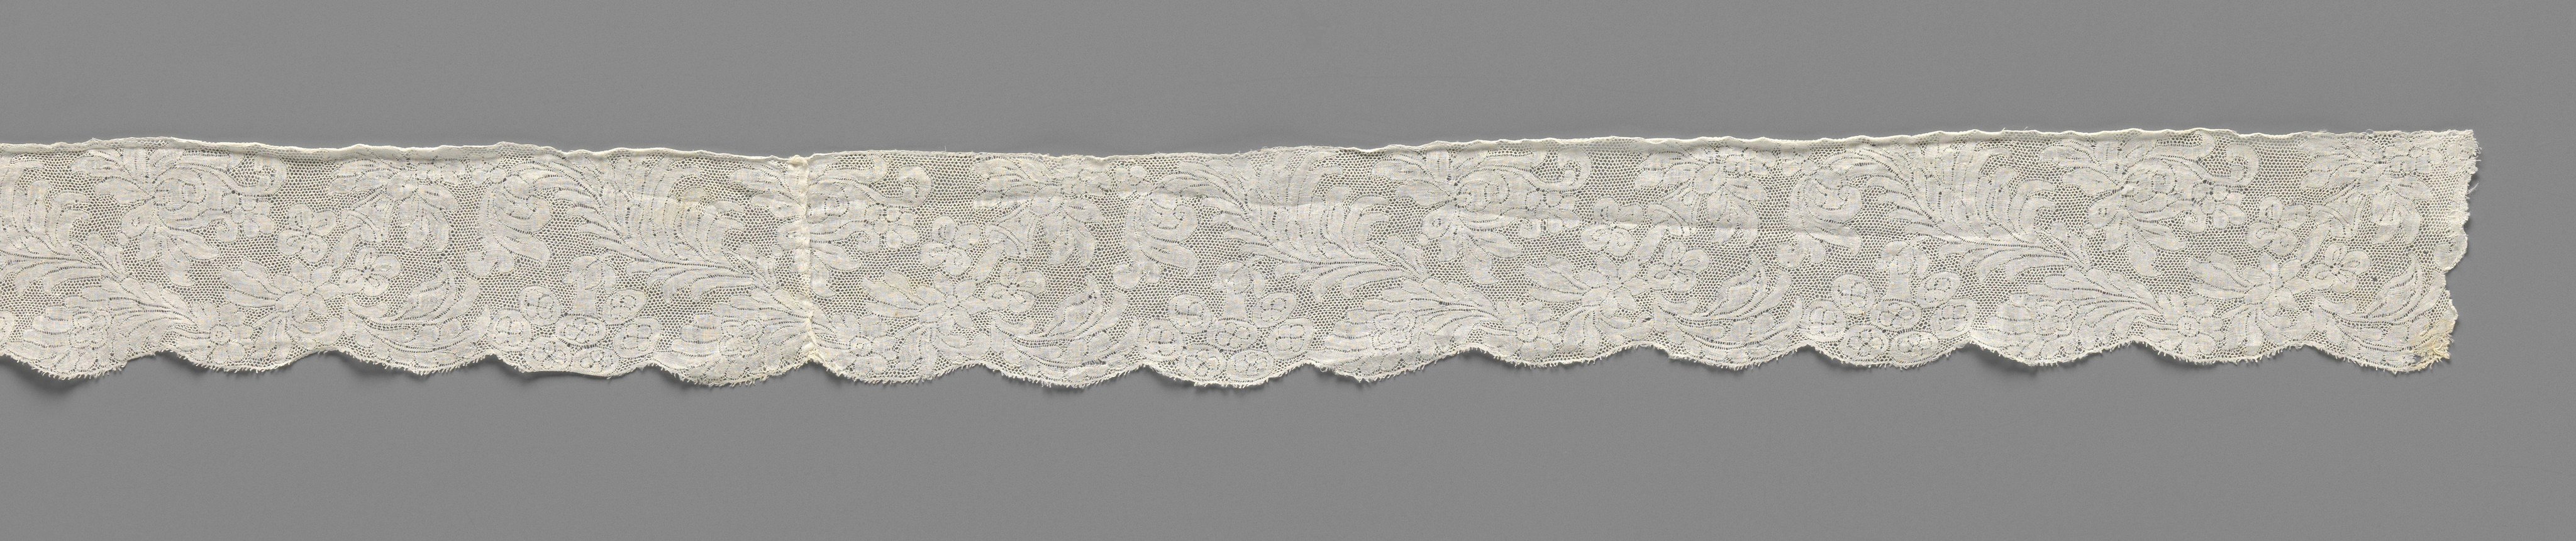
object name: strip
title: Strook kloskant met kelkbloemen en gevederde bladeren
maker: Anonymous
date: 1740-1760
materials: linen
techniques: lace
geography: southern netherlands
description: Strook naturelkleurige kloskant: Valenciennes-kant. Het zich herhalende patroon bestaat uit een schuin geplaatst en gespiegeld s-vormig gevederd blad. Onder het blad hangt een trosbloem met zeven rozetbloempjes in ovaaltjes. Naast het blad staan twee naar elkaar toegewende kelkvormige bloemen met daaronder enkele kleinere bloemen en een pluimvormig blad dat langs de onderzijde van de strook ligt. De motieven zijn gemaakt in linnenslag met opengewerkte randjes en uitsparingen. De motieven zijn met elkaar verbonden door een fijne ronde Valenciennes-grond. De bovenzijde van de strook is recht afgewerkt. De regelmatige schulpenrand vormt zich om het patroon en is afgewerkt met picots.